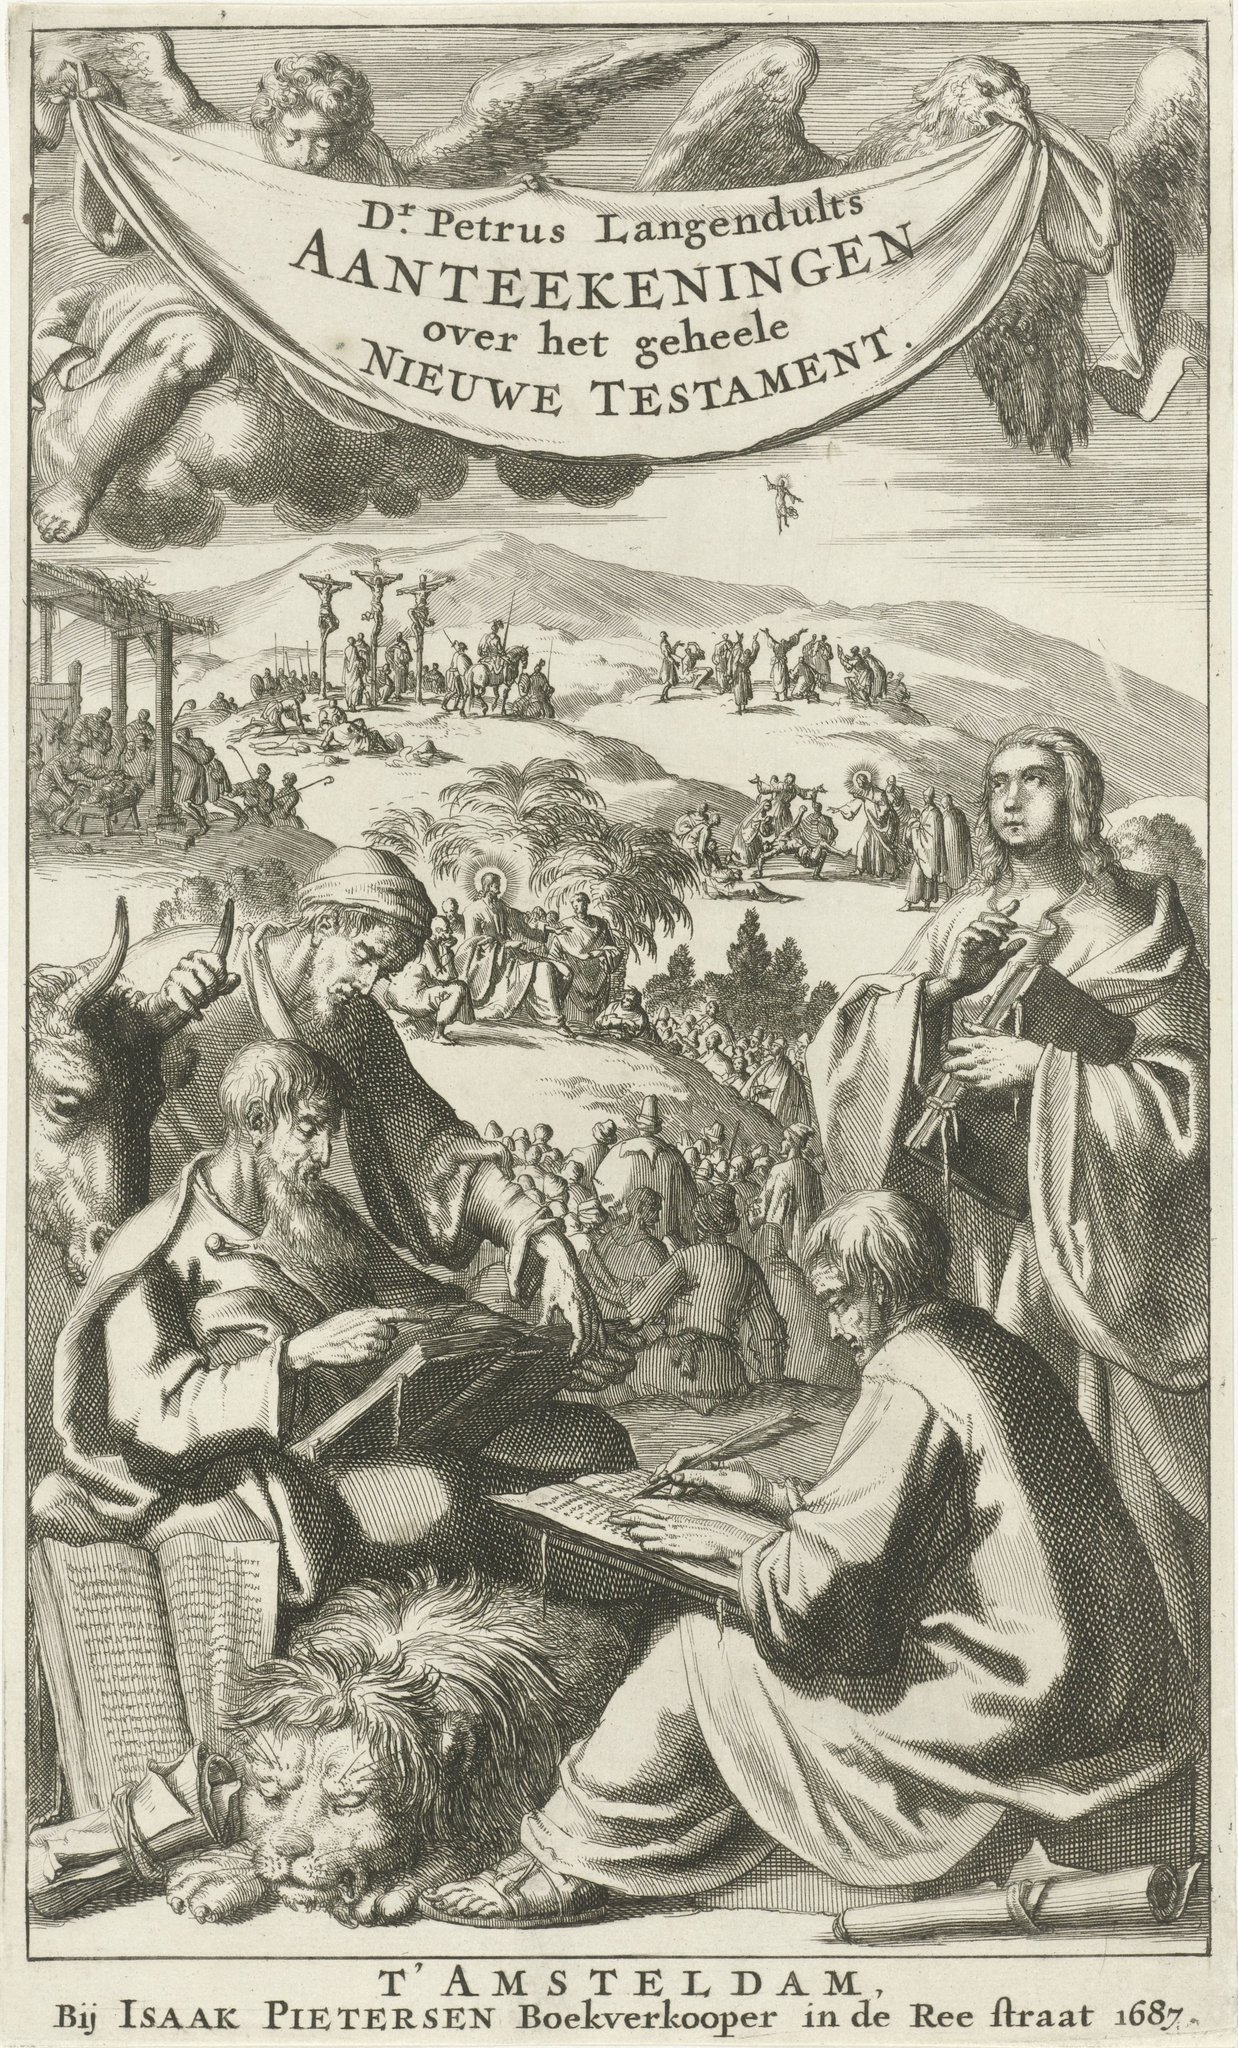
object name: titelblad, titelpagina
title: De vier evangelisten in het gezelschap van een leeuw en stier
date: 1689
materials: paper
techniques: engraving, etching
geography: amsterdam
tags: the ascension (christ surrounded by radiant light or in a mandorla), story of the birth of christ (luke 2:1-20), christ healing possessed people, christ's sermon on the mount (matthew 5-7), the crucifixion of christ: christ's death on the cross; golgotha (matthew 27:45-58; mark 15:33-45; luke 23:44-52; john 19:25-38), the evangelists writing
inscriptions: collector's mark: Lugt 2228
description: De vier evangelisten in het gezelschap van een leeuw en stier. Op de achtergrond zijn de geboorte van Christus, de bergrede, de genezing van een bezetene, de kruisiging en hemelvaart van Christus weergegeven.